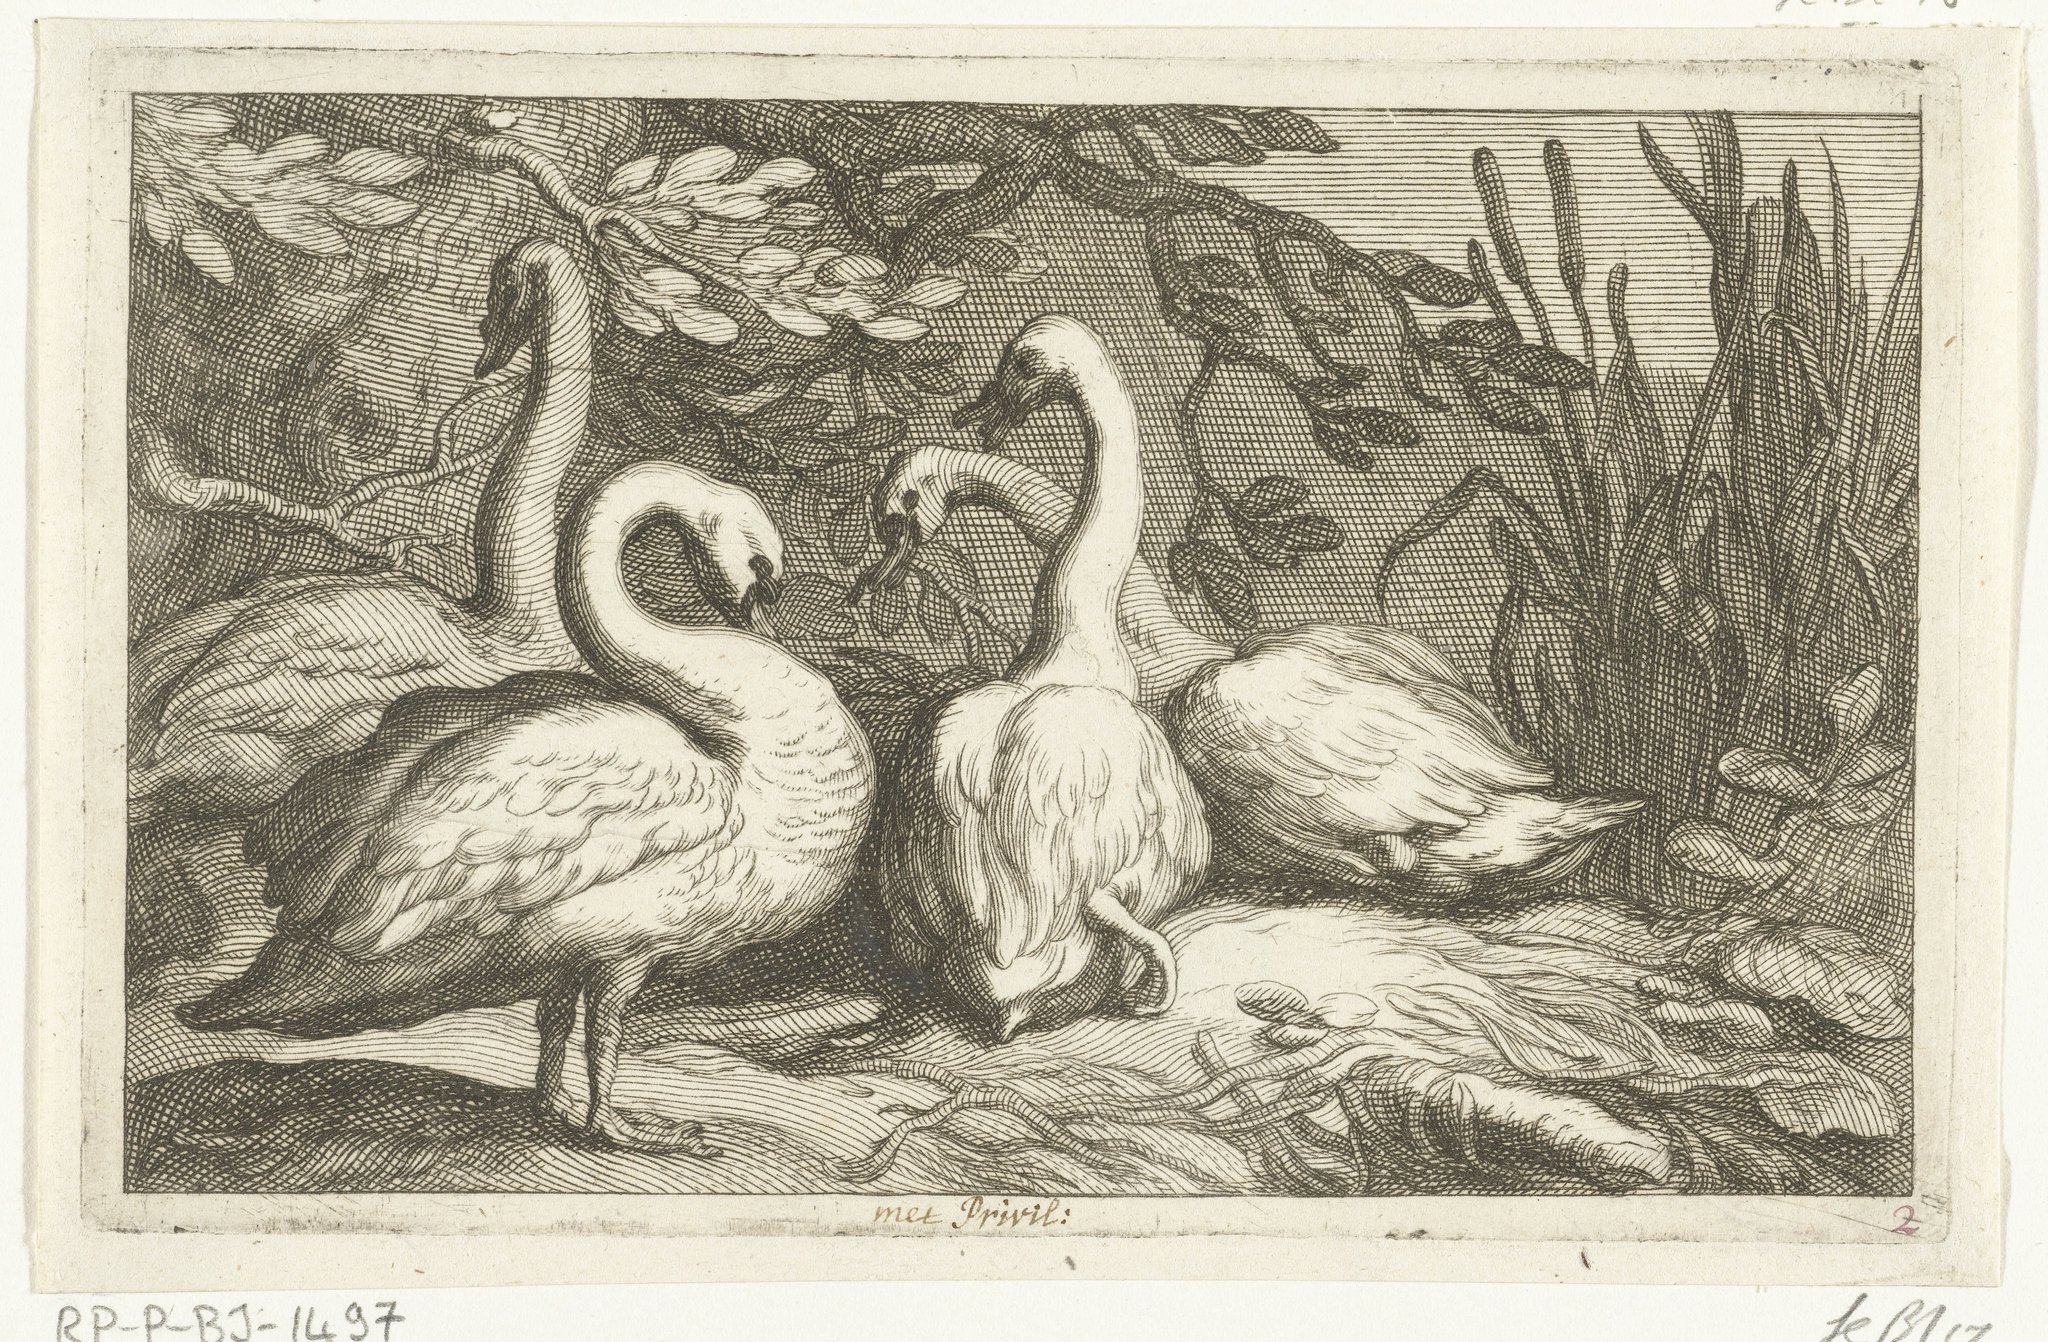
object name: print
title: Dieren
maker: frederick bloemaert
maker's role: print maker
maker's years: 1614-1669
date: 1635-1670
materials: paper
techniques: engraving, etching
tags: water-birds: swan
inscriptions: collector's mark: Lugt 240, inscription: ‘met Privil:’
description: Vier zwanen aan de waterkant tussen het riet. Prent uit een serie van 14 prenten met verschillende inheemse dieren.